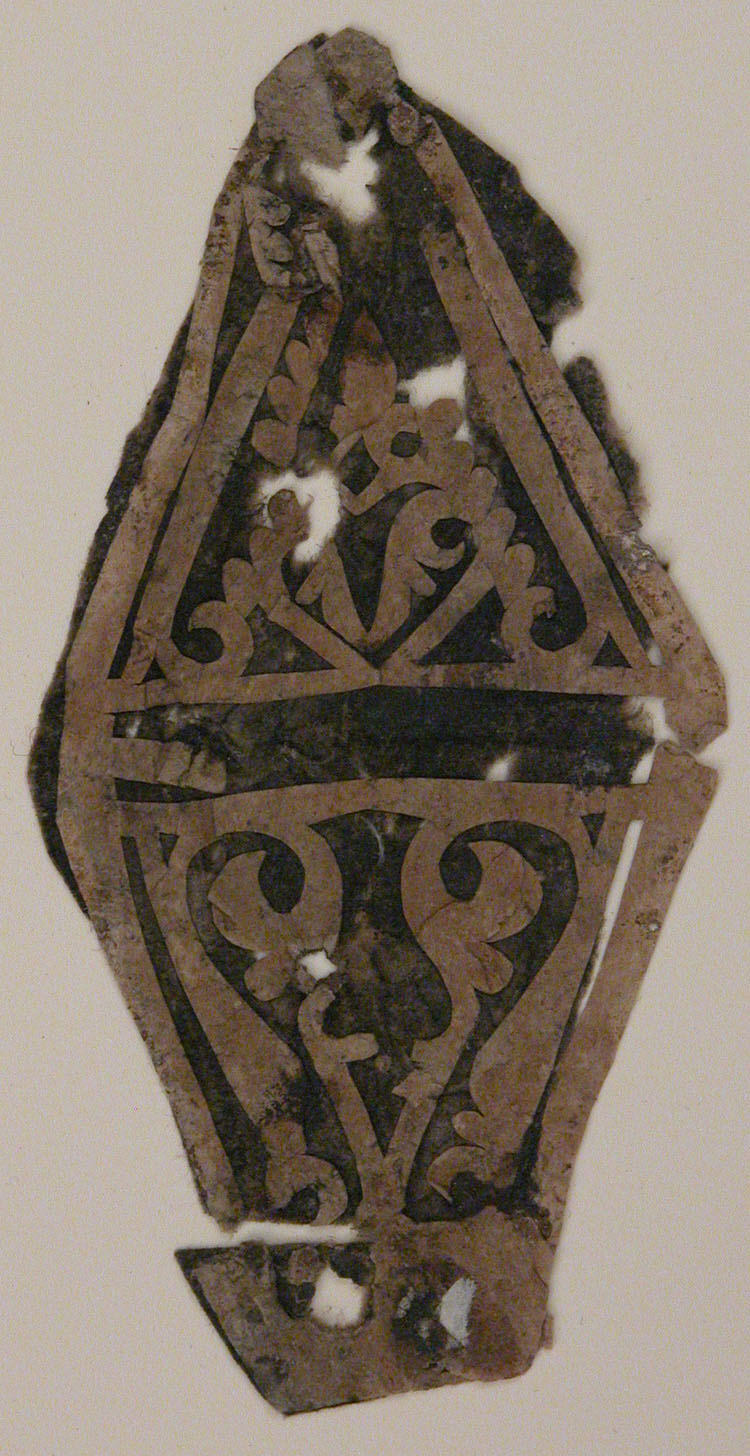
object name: paper cut out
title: Paper Cut-Out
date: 901-1000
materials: paper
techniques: cutting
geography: egypt